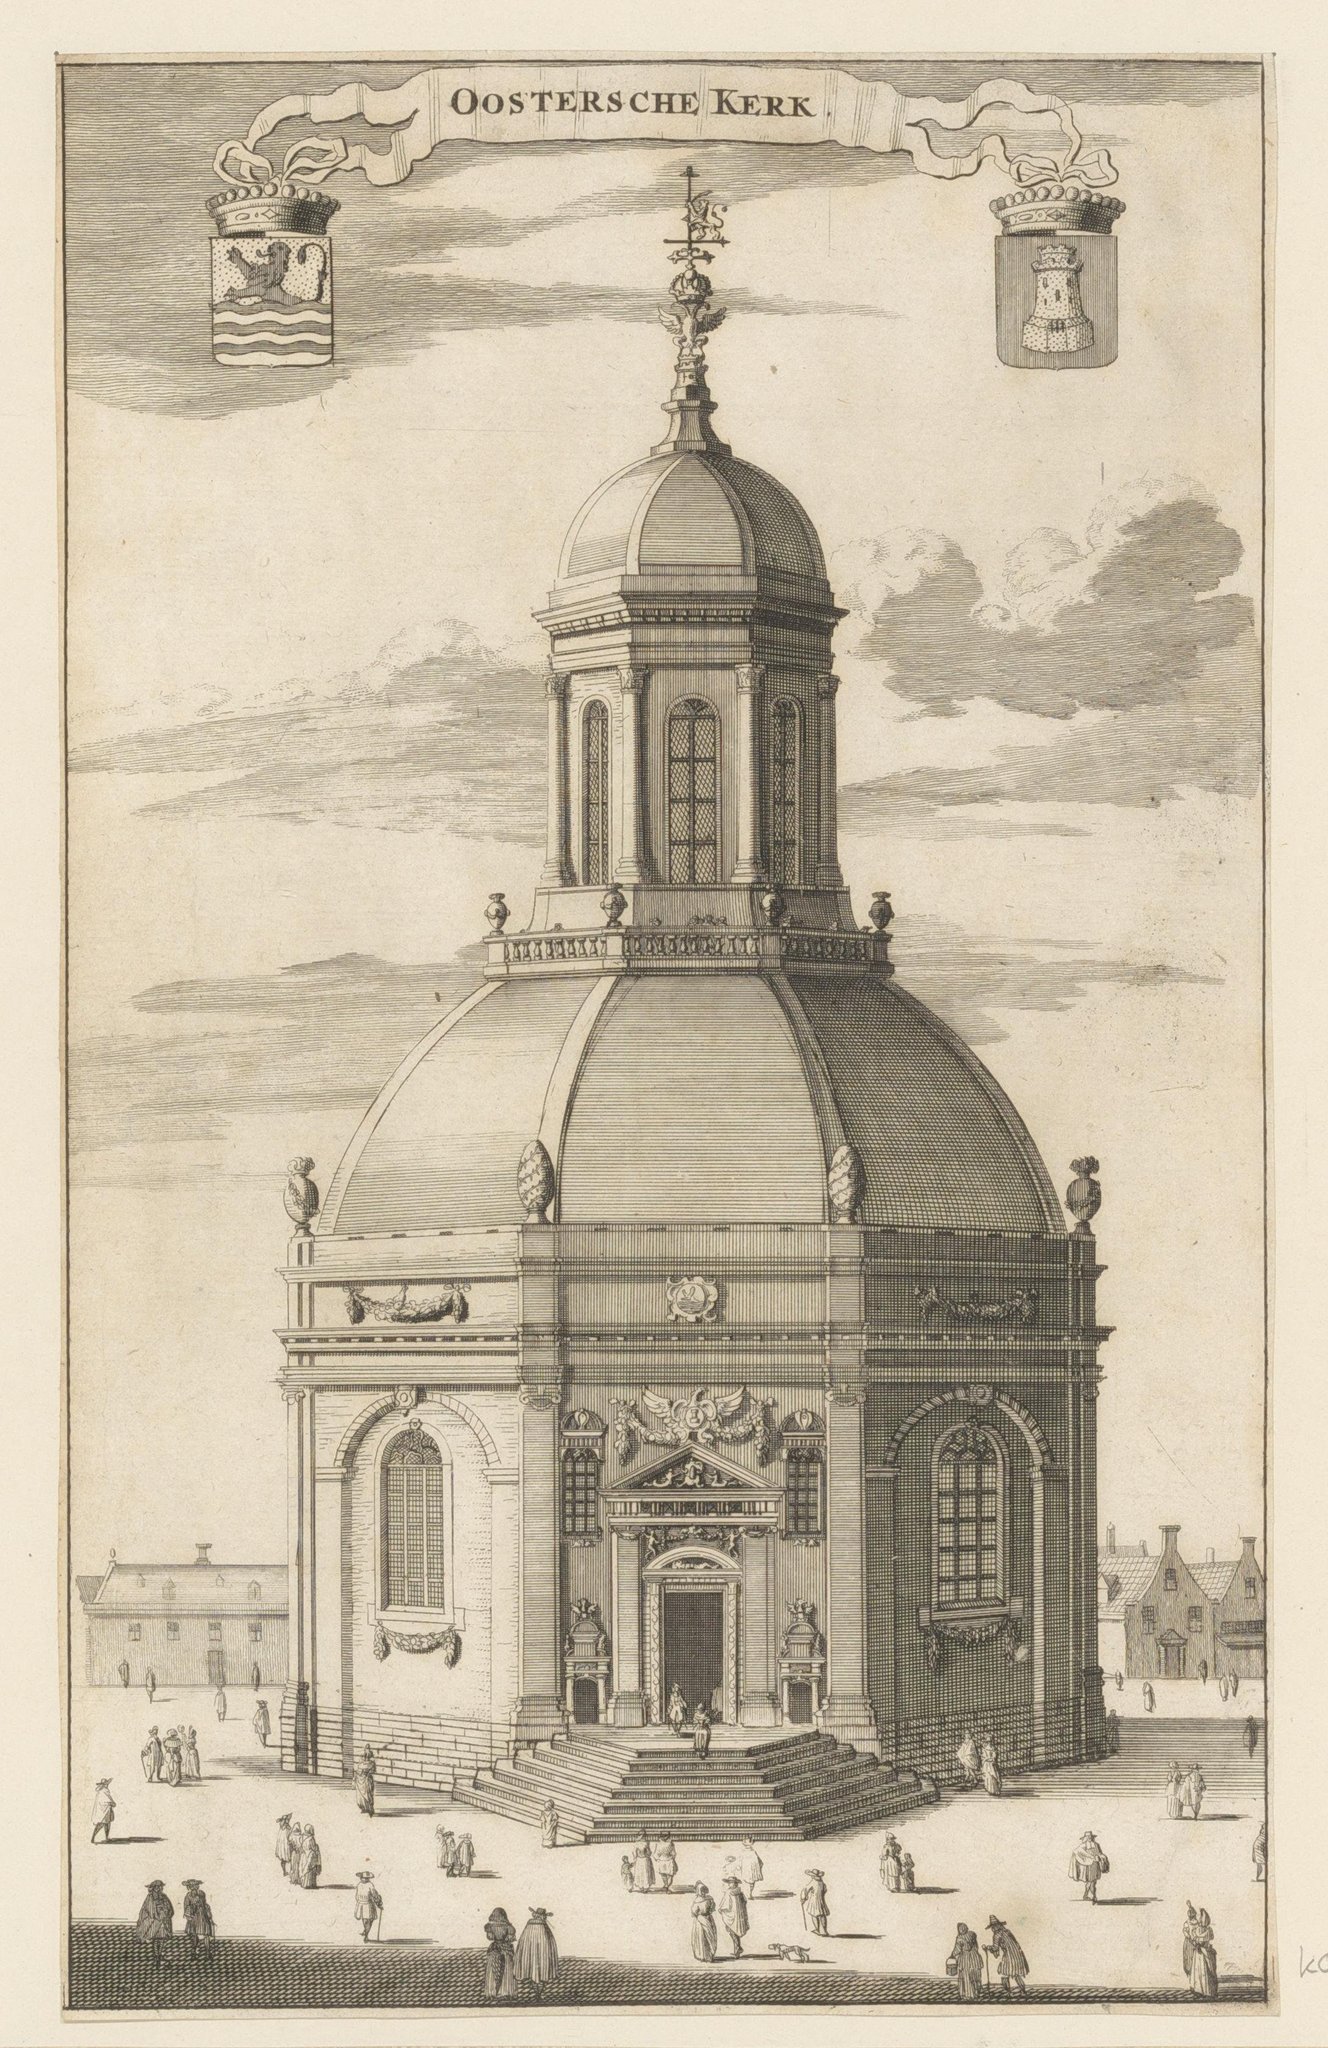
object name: print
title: Gezicht op de Oostkerk te Middelburg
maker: Anonymous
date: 1696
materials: paper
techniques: engraving, etching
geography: netherlands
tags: church (exterior)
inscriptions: collector's mark, collector's mark: Lugt 1641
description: Oorspronkelijk van één plaat gedrukt met één andere voorstelling. Prent in zijn geheel eerst gebruikt in: Smallegange, Mattheus. Nieuwe Cronyk van Zeeland (…). Middelburg en Amsterdam: Johannes Meertens en Abraham van Someren, 1696. Later los ook gebruikt in: Aa, Pieter van der. La galerie agreable du monde (...). 66 delen. Leiden: Pieter van der Aa, 1728, dl. 20.